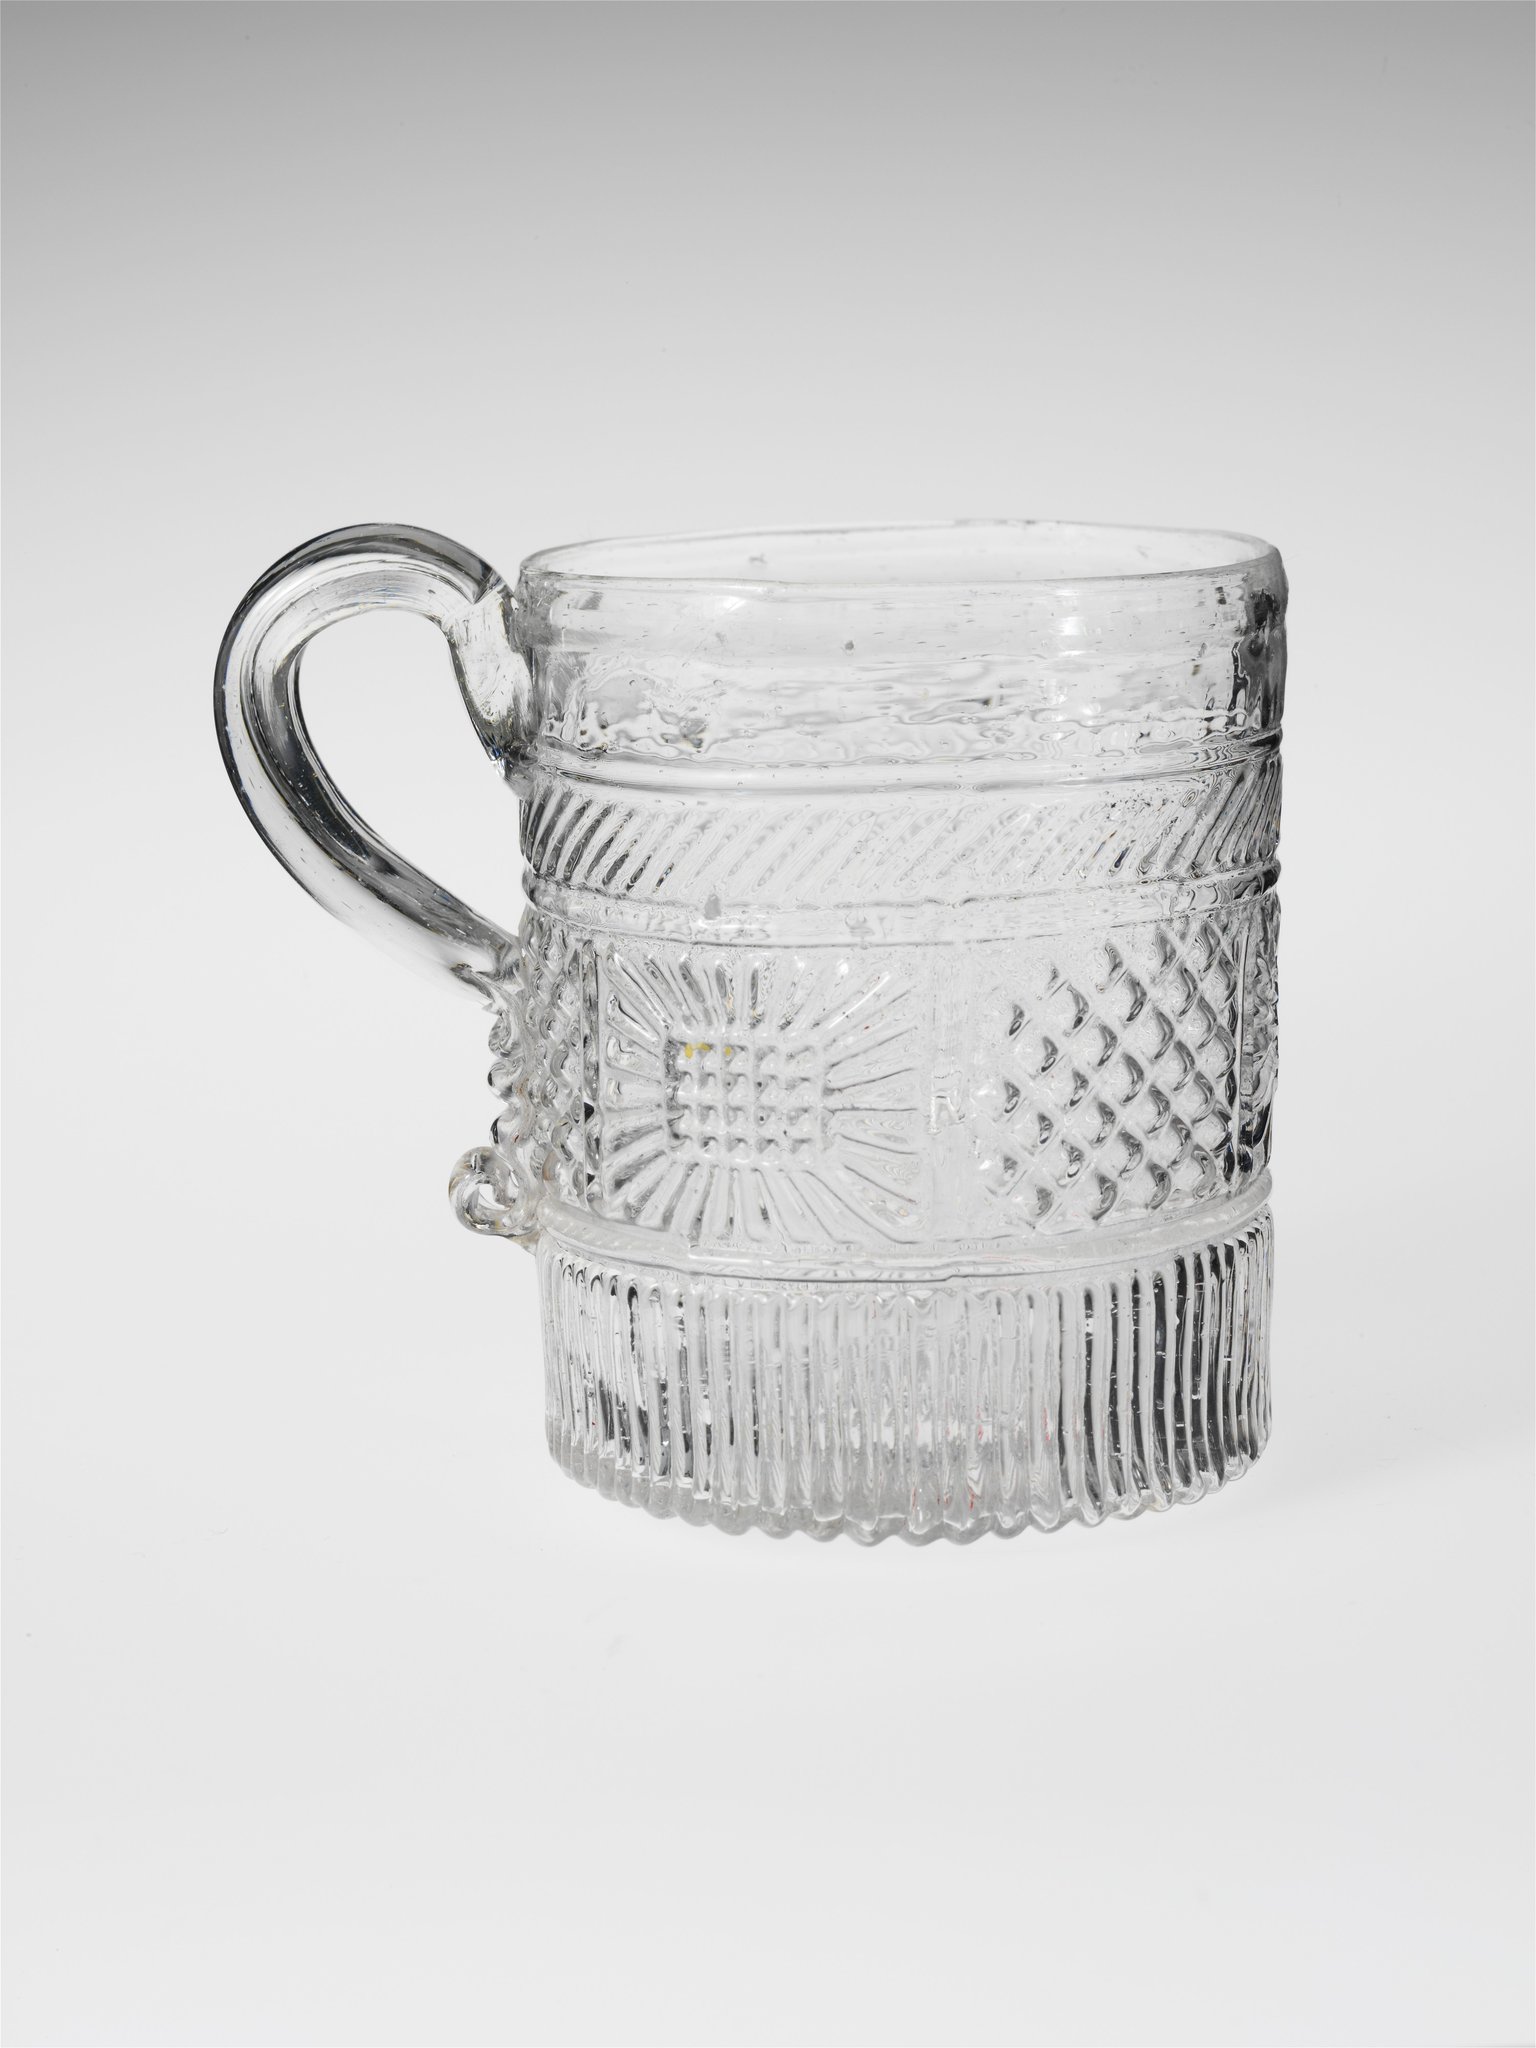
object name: mug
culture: american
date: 1820-1840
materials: glass, lead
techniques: glassblowing, molding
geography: united states